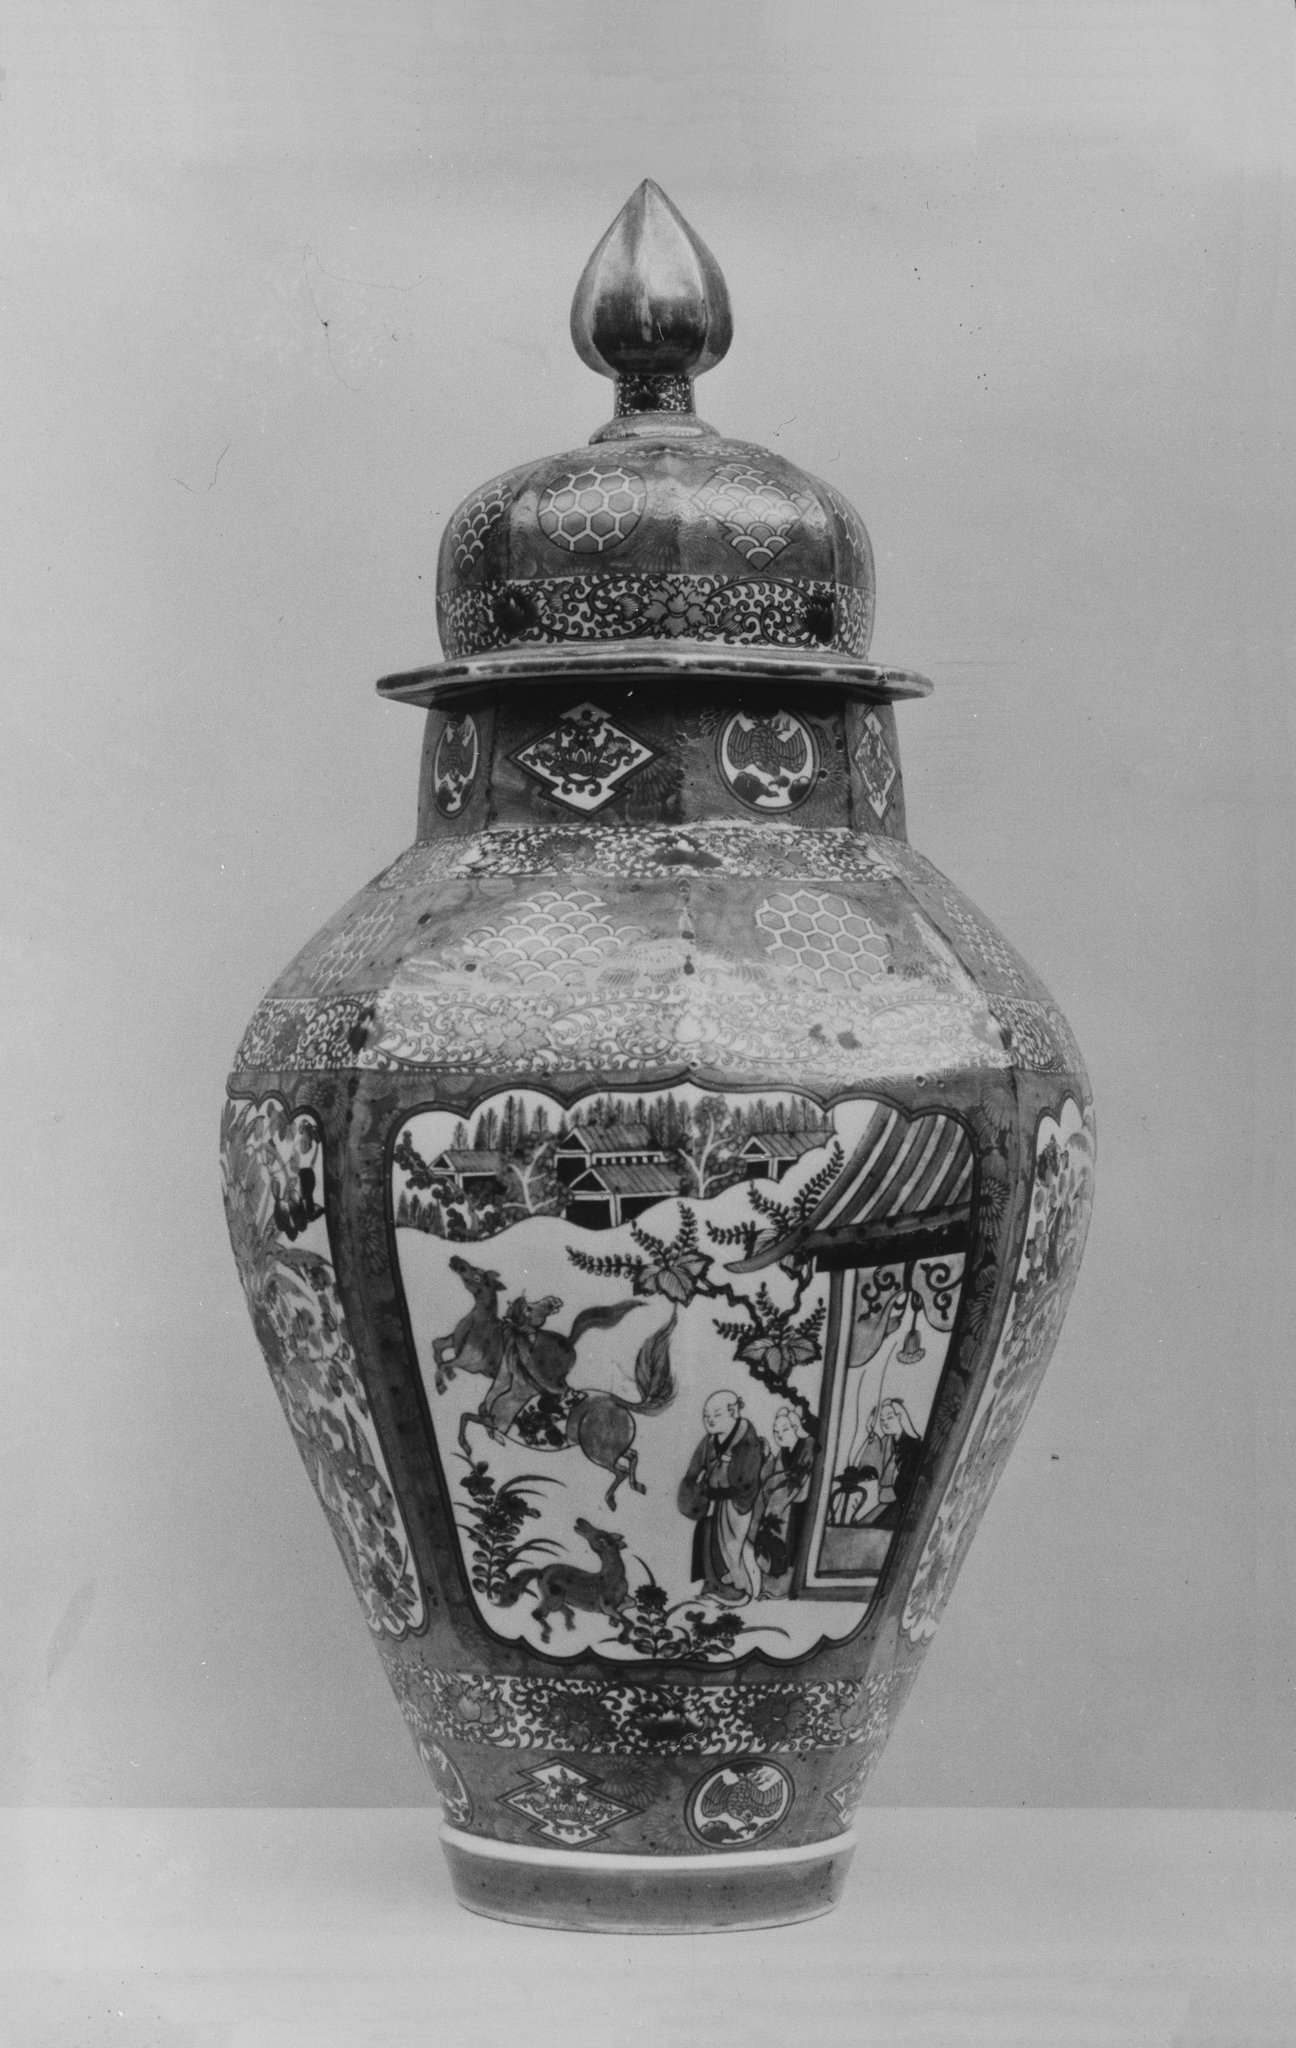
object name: vase with cover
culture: japanese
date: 1720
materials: enamel, porcelain